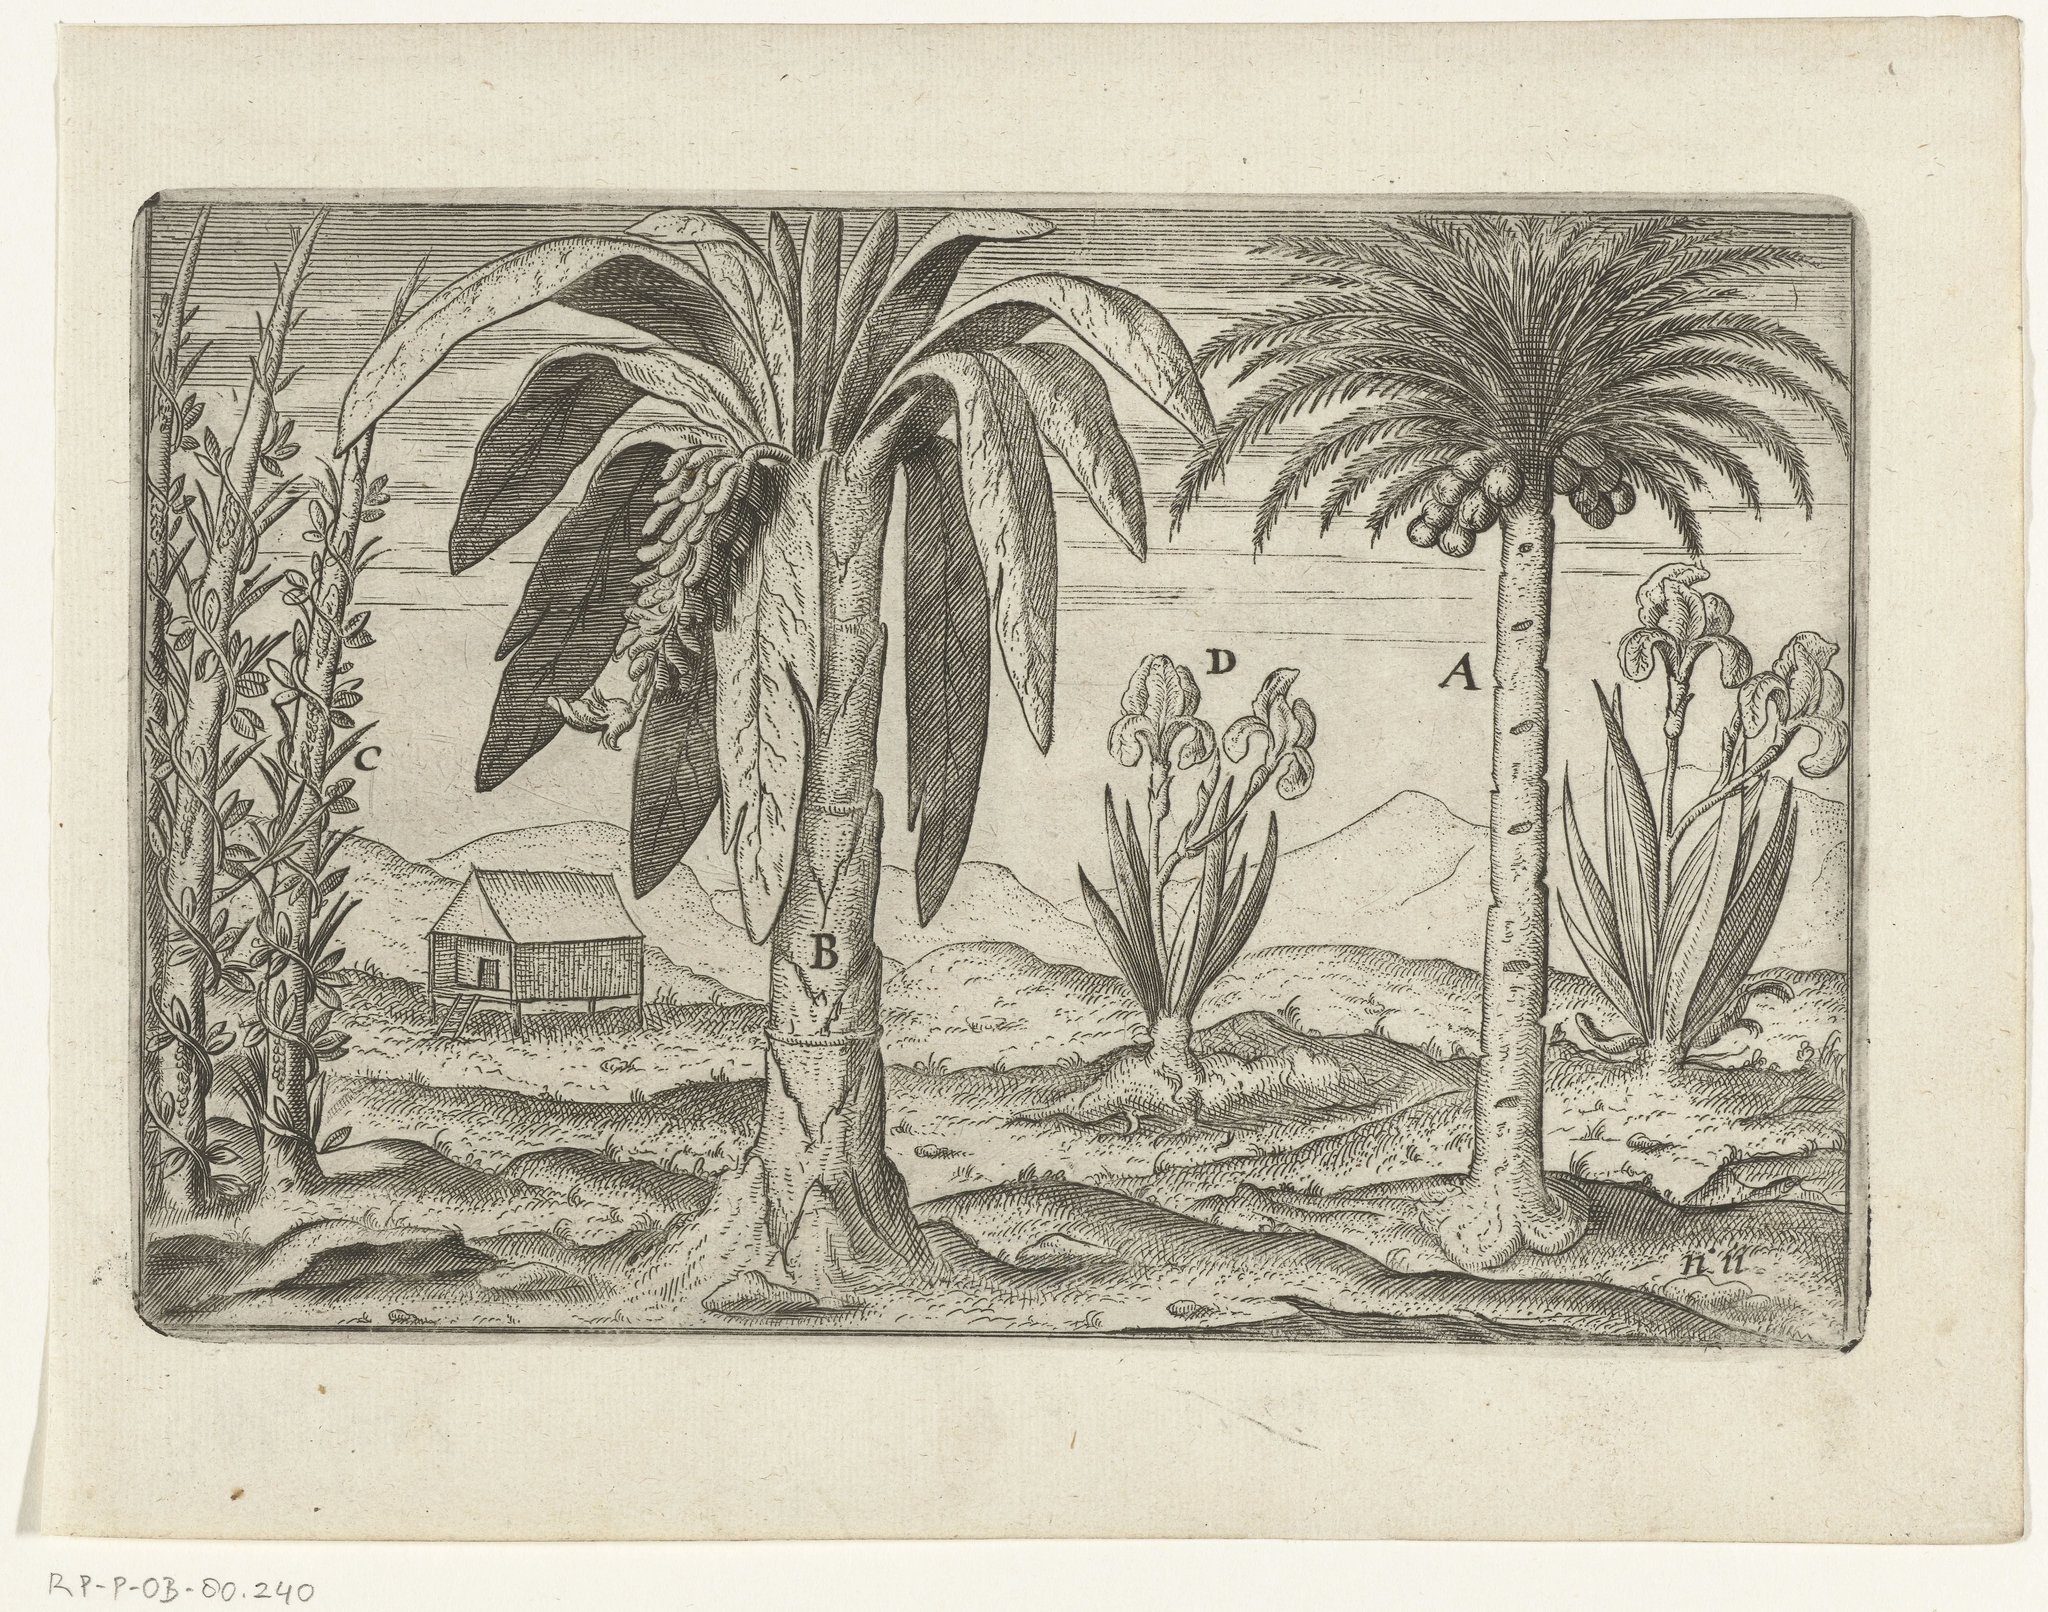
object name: print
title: Inheemse gewassen van Sumatra, 1596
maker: Anonymous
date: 1597-1598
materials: paper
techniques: engraving, etching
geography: northern netherlands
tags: plants; vegetation, landscapes in tropical and sub-tropical regions, exploration, expedition, voyage of discovery, sumatra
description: Gebruikt als illustratie eerst in: Willem Lodewijcksz, D'eerste boeck. Historie van Indien, waer inne verhaelt is de avontueren die de Hollandtsche schepen bejeghent zijn, Cornelis Claes, Amsterdam 1598. In deze opgewerkte staat gebruikt in: De Eerste Schipvaerd der Hollandsche Natie naer Oost-Indien, waer inne verhaelt wordt al wat haer sonderlings onder wegen bejegent is ... ghetrocken uyt verscheyden Iournalen ofte dagh-registers daer van ghemaeckt, zeer vermaeckelijck ende nut om lesen. Opgenomen in: I. Commelin, Begin ende voortgangh, van de Vereenighde Nederlantsche Geoctroyeerde Oost-Indische Compagnie, J. Janssonius, Amsterdam 1646. Genummerd: 11.